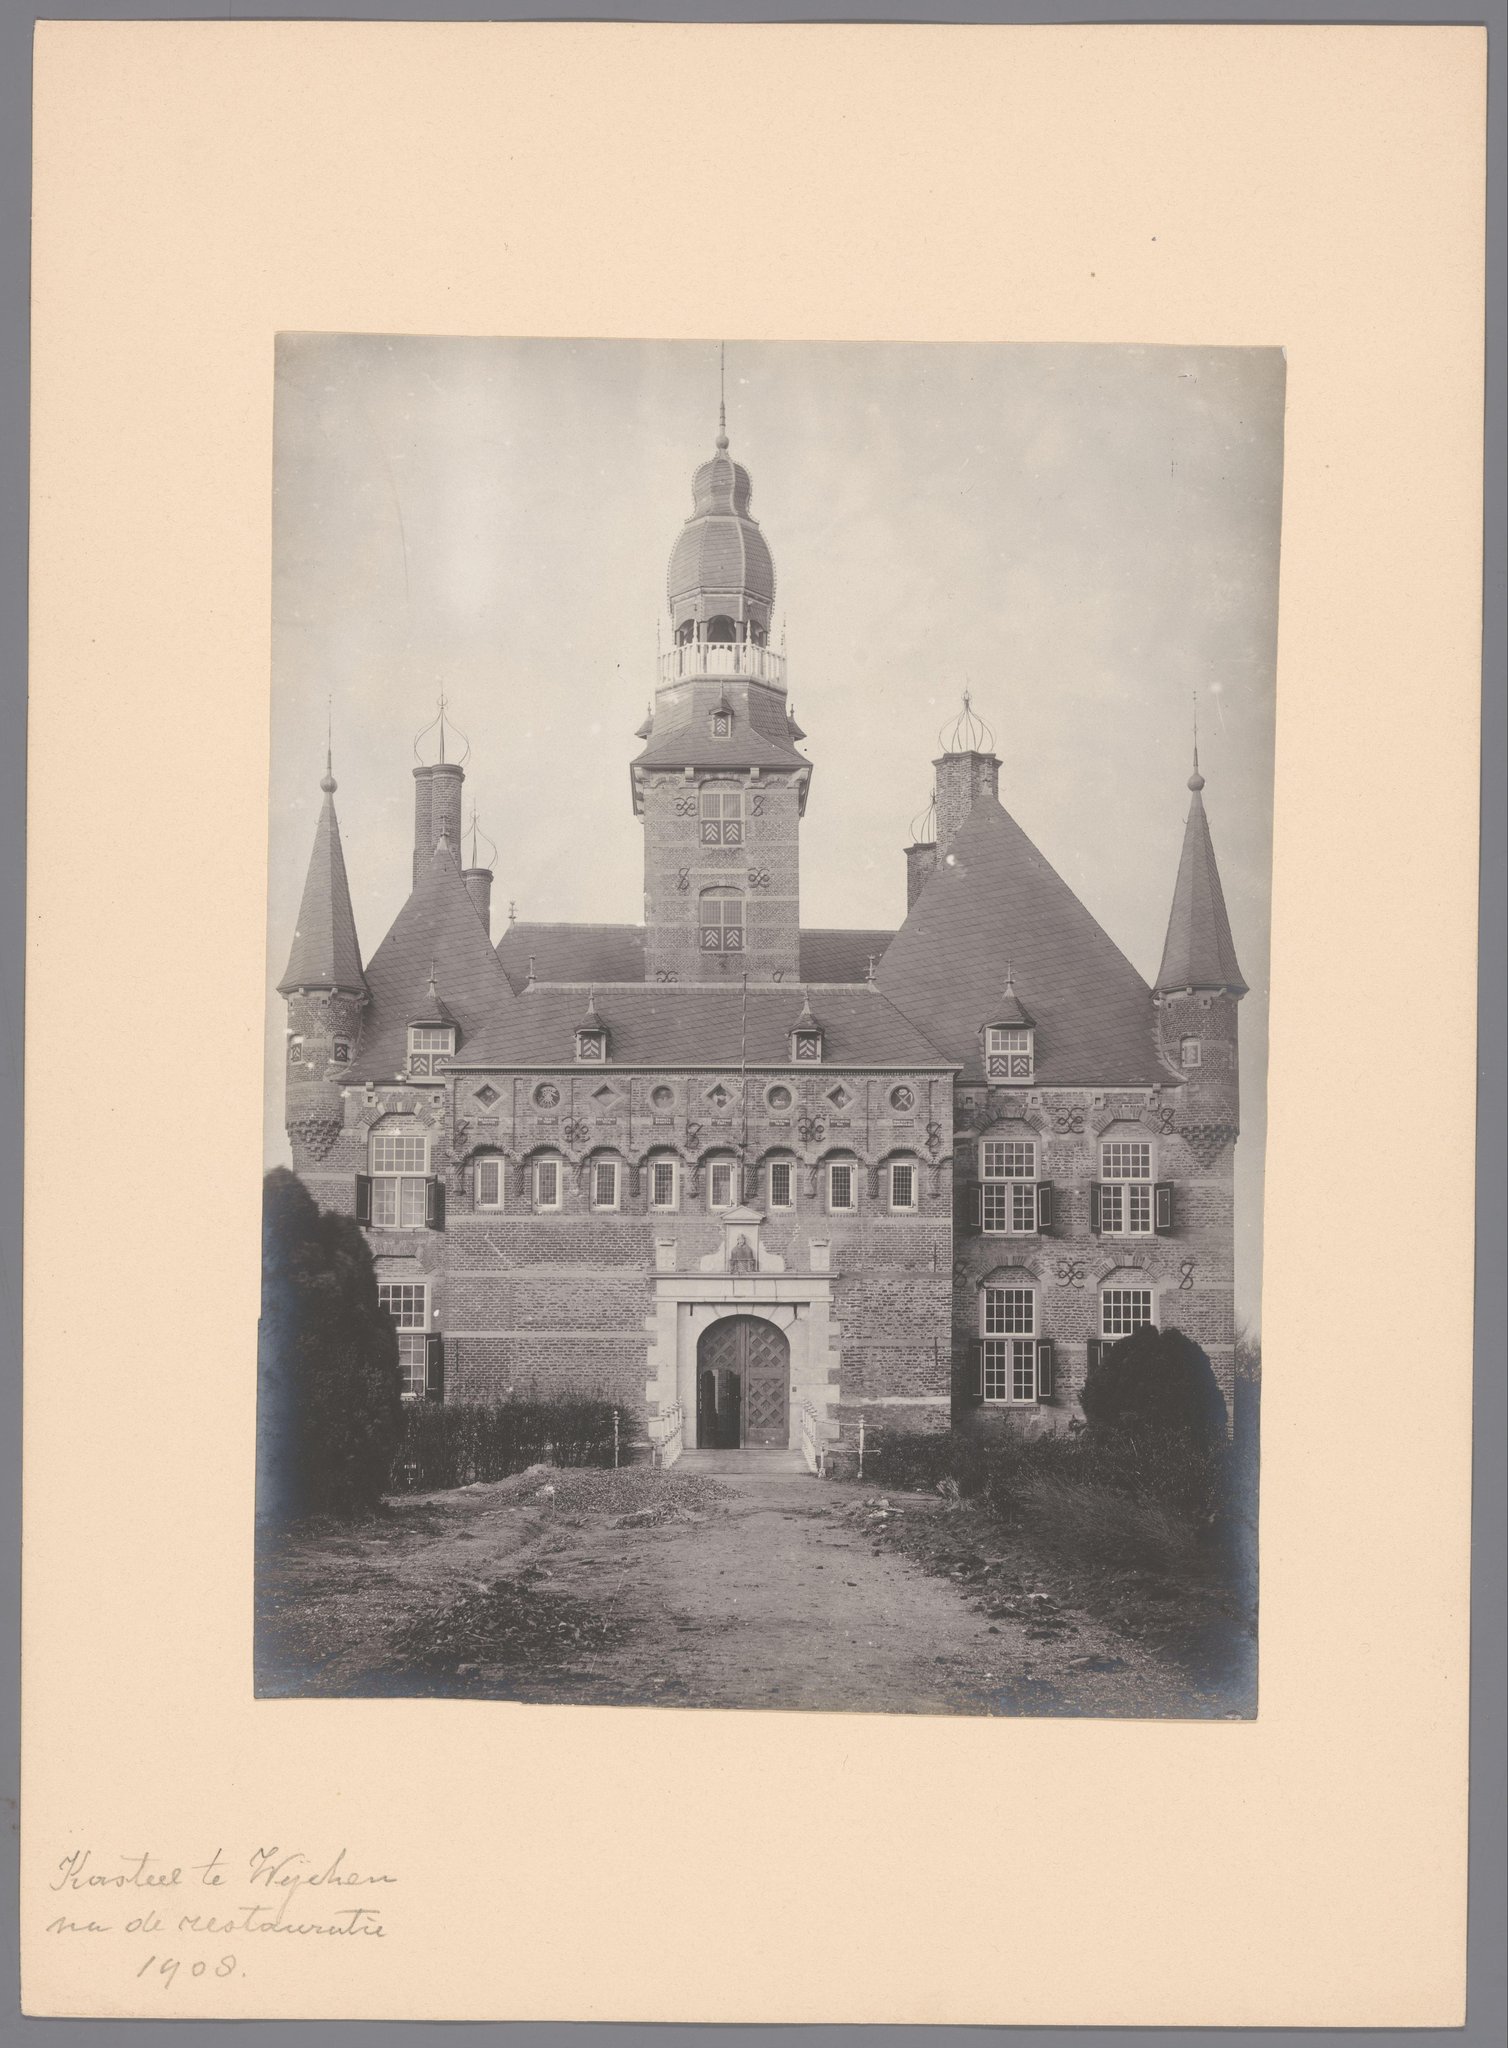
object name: photograph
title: Gezicht op het Kasteel van Wijchen na de restauratie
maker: anoniem (monumentenzorg)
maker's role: fotograaf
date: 1908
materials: cardboard, photographic support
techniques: gelatin silver print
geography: wijchen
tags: castle, landscape with tower or castle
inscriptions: annotation: ‘Kasteel te Wijchen na de restauratie 1908’